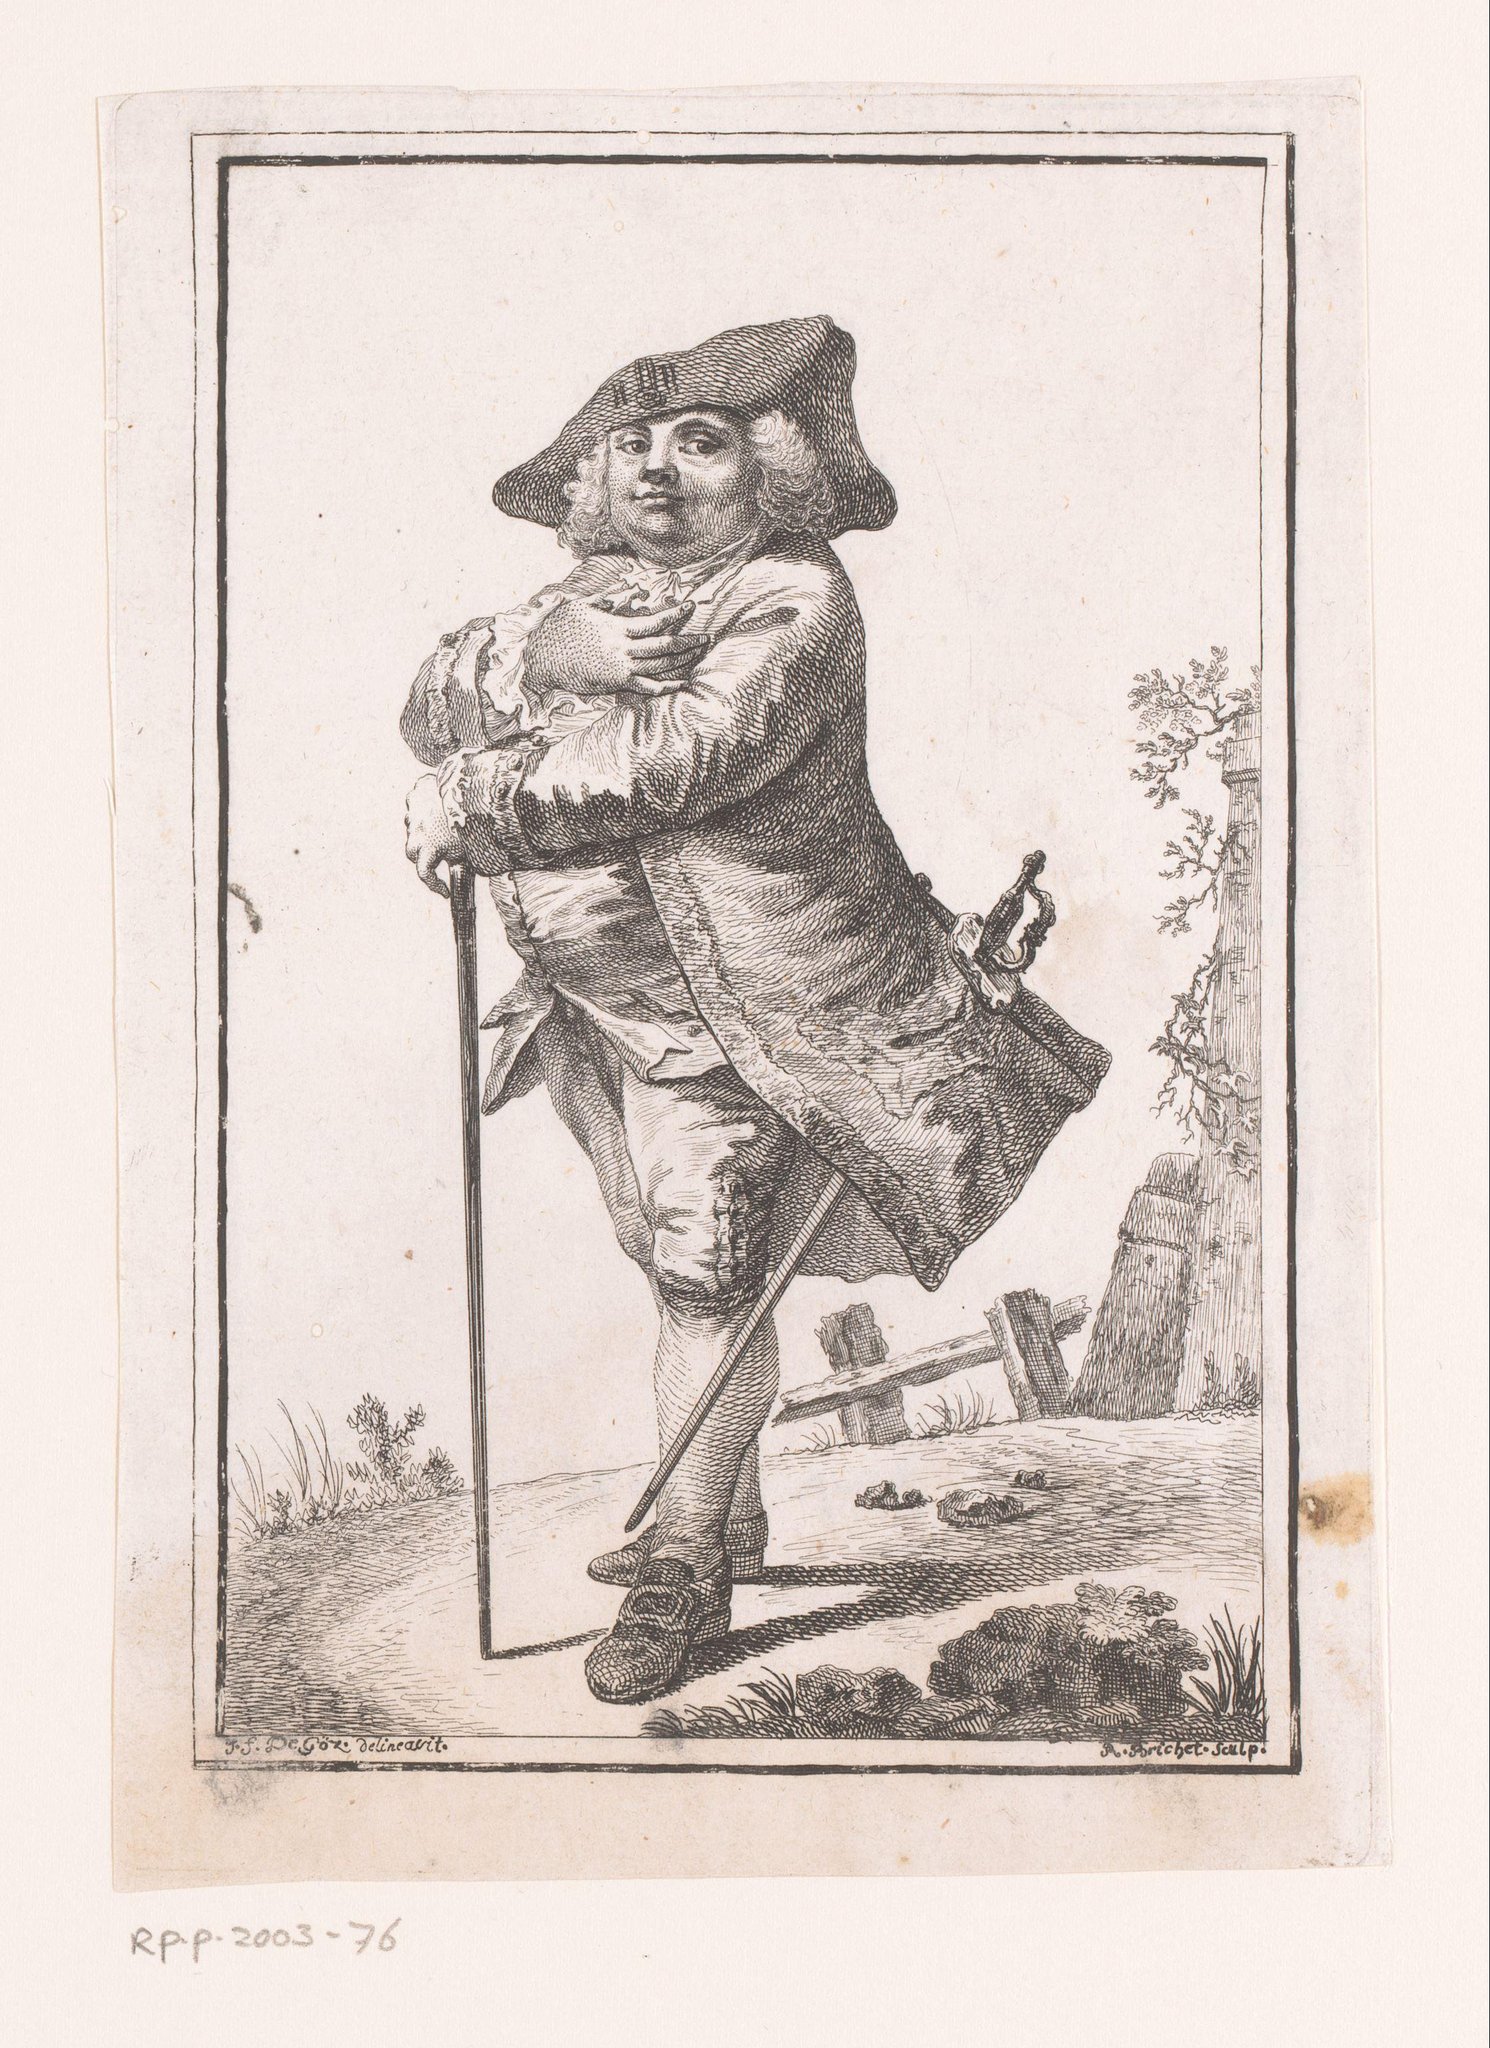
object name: print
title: Man met hoed en zwaard leunend op een stok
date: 1783-1784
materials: paper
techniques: etching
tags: walking-stick, staff, adult man, hacking and thrusting weapons: sword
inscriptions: collector's mark: Lugt 2228, collector's mark: Lugt 2760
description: Prent uit een serie getiteld: "Exercises d'imagination de differens Caractères et Formes humaines inventés peints et dessinés par J. F. de Goez Suite 1", bestaande uit honderd platen met verschillende figuren met elk een eigen titel. Plaat 1 t/m 84 zijn van de hand van Brichet naar ontwerp van Von Goez en plaat 85 t/m 100 zijn door Von Goez zelf geëtst.